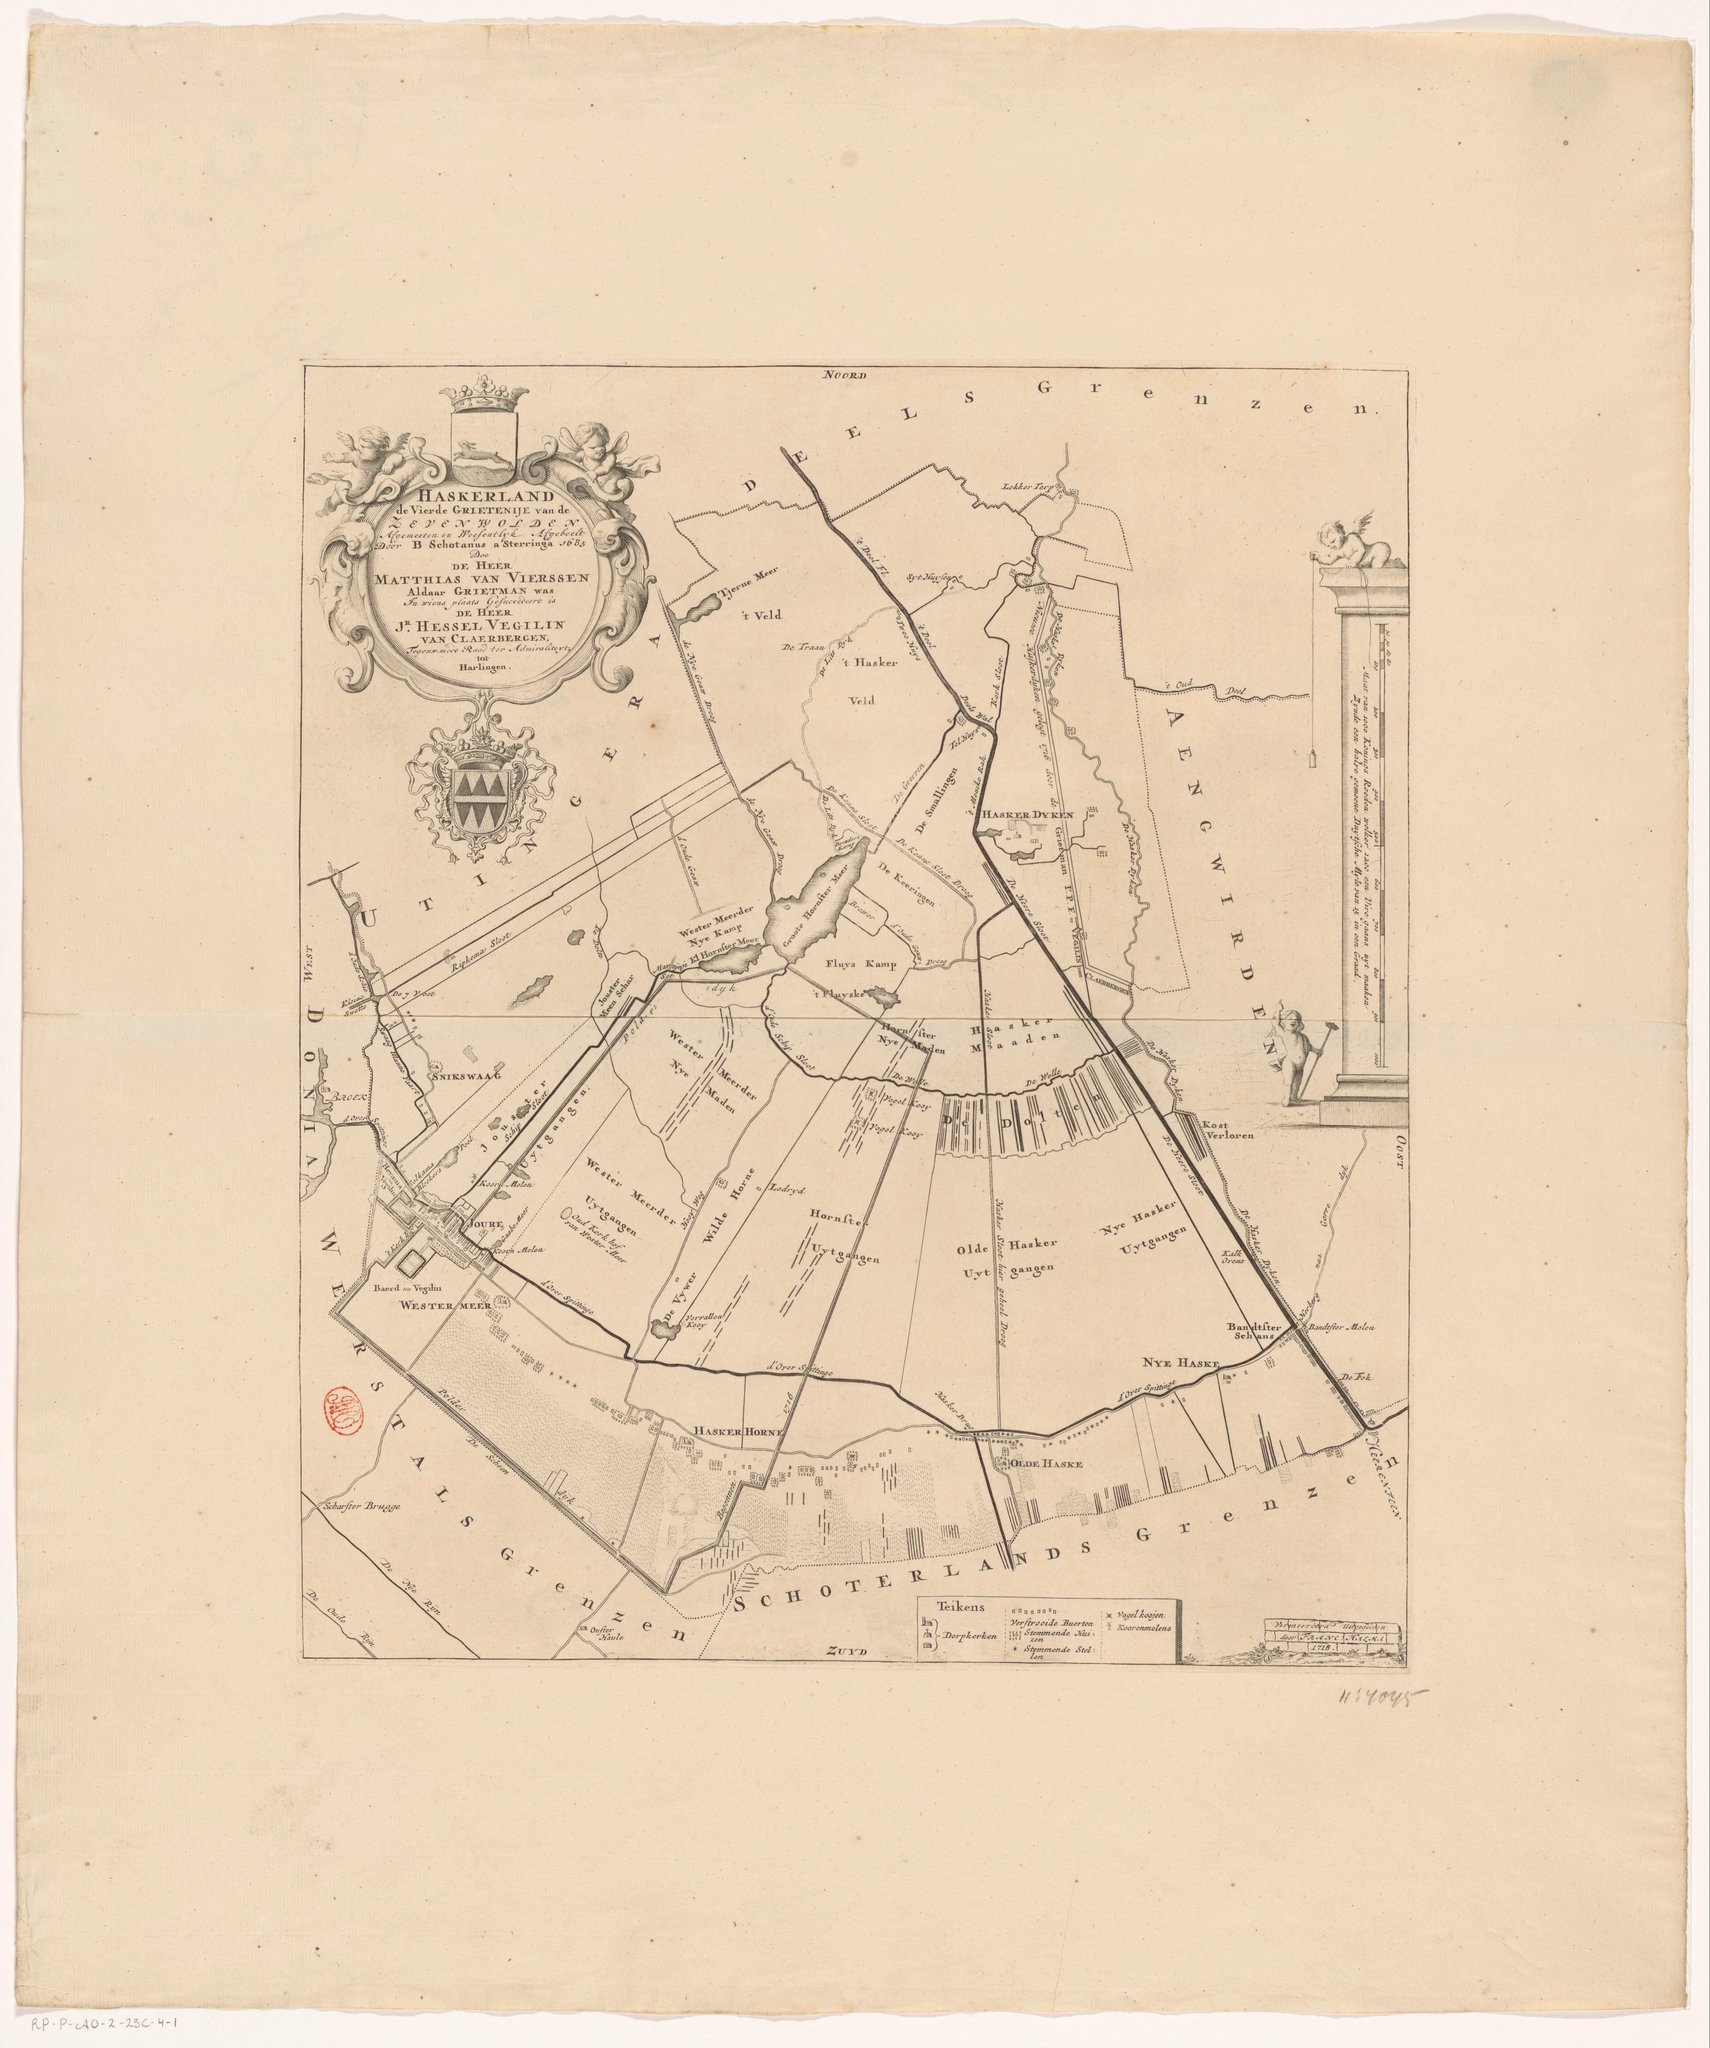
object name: print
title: Haskerland de vierde grietenije van de Zevenwolden (...)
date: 1698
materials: paper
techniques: engraving, etching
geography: friesland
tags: coat of arms (as symbol of the state, etc.), maps of separate countries or regions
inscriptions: label: ‘264’, collector's mark: Lugt 195, collector's mark: Lugt 2228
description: Linksboven cartouche met titel, bestuurlijke informatie over de grietenij en de wapens van Haskerland en van grietman Matthias van Vierssen. Rechts een zuil met een schaalstok: Maat van 1000 konings roeden welker 1200 een uire gaans uyt maaken zynde een halve gemeene Duytsche myle van 15 in een graad. Daaromheen putti met landmeetapparatuur. Rechtsonder legenda.